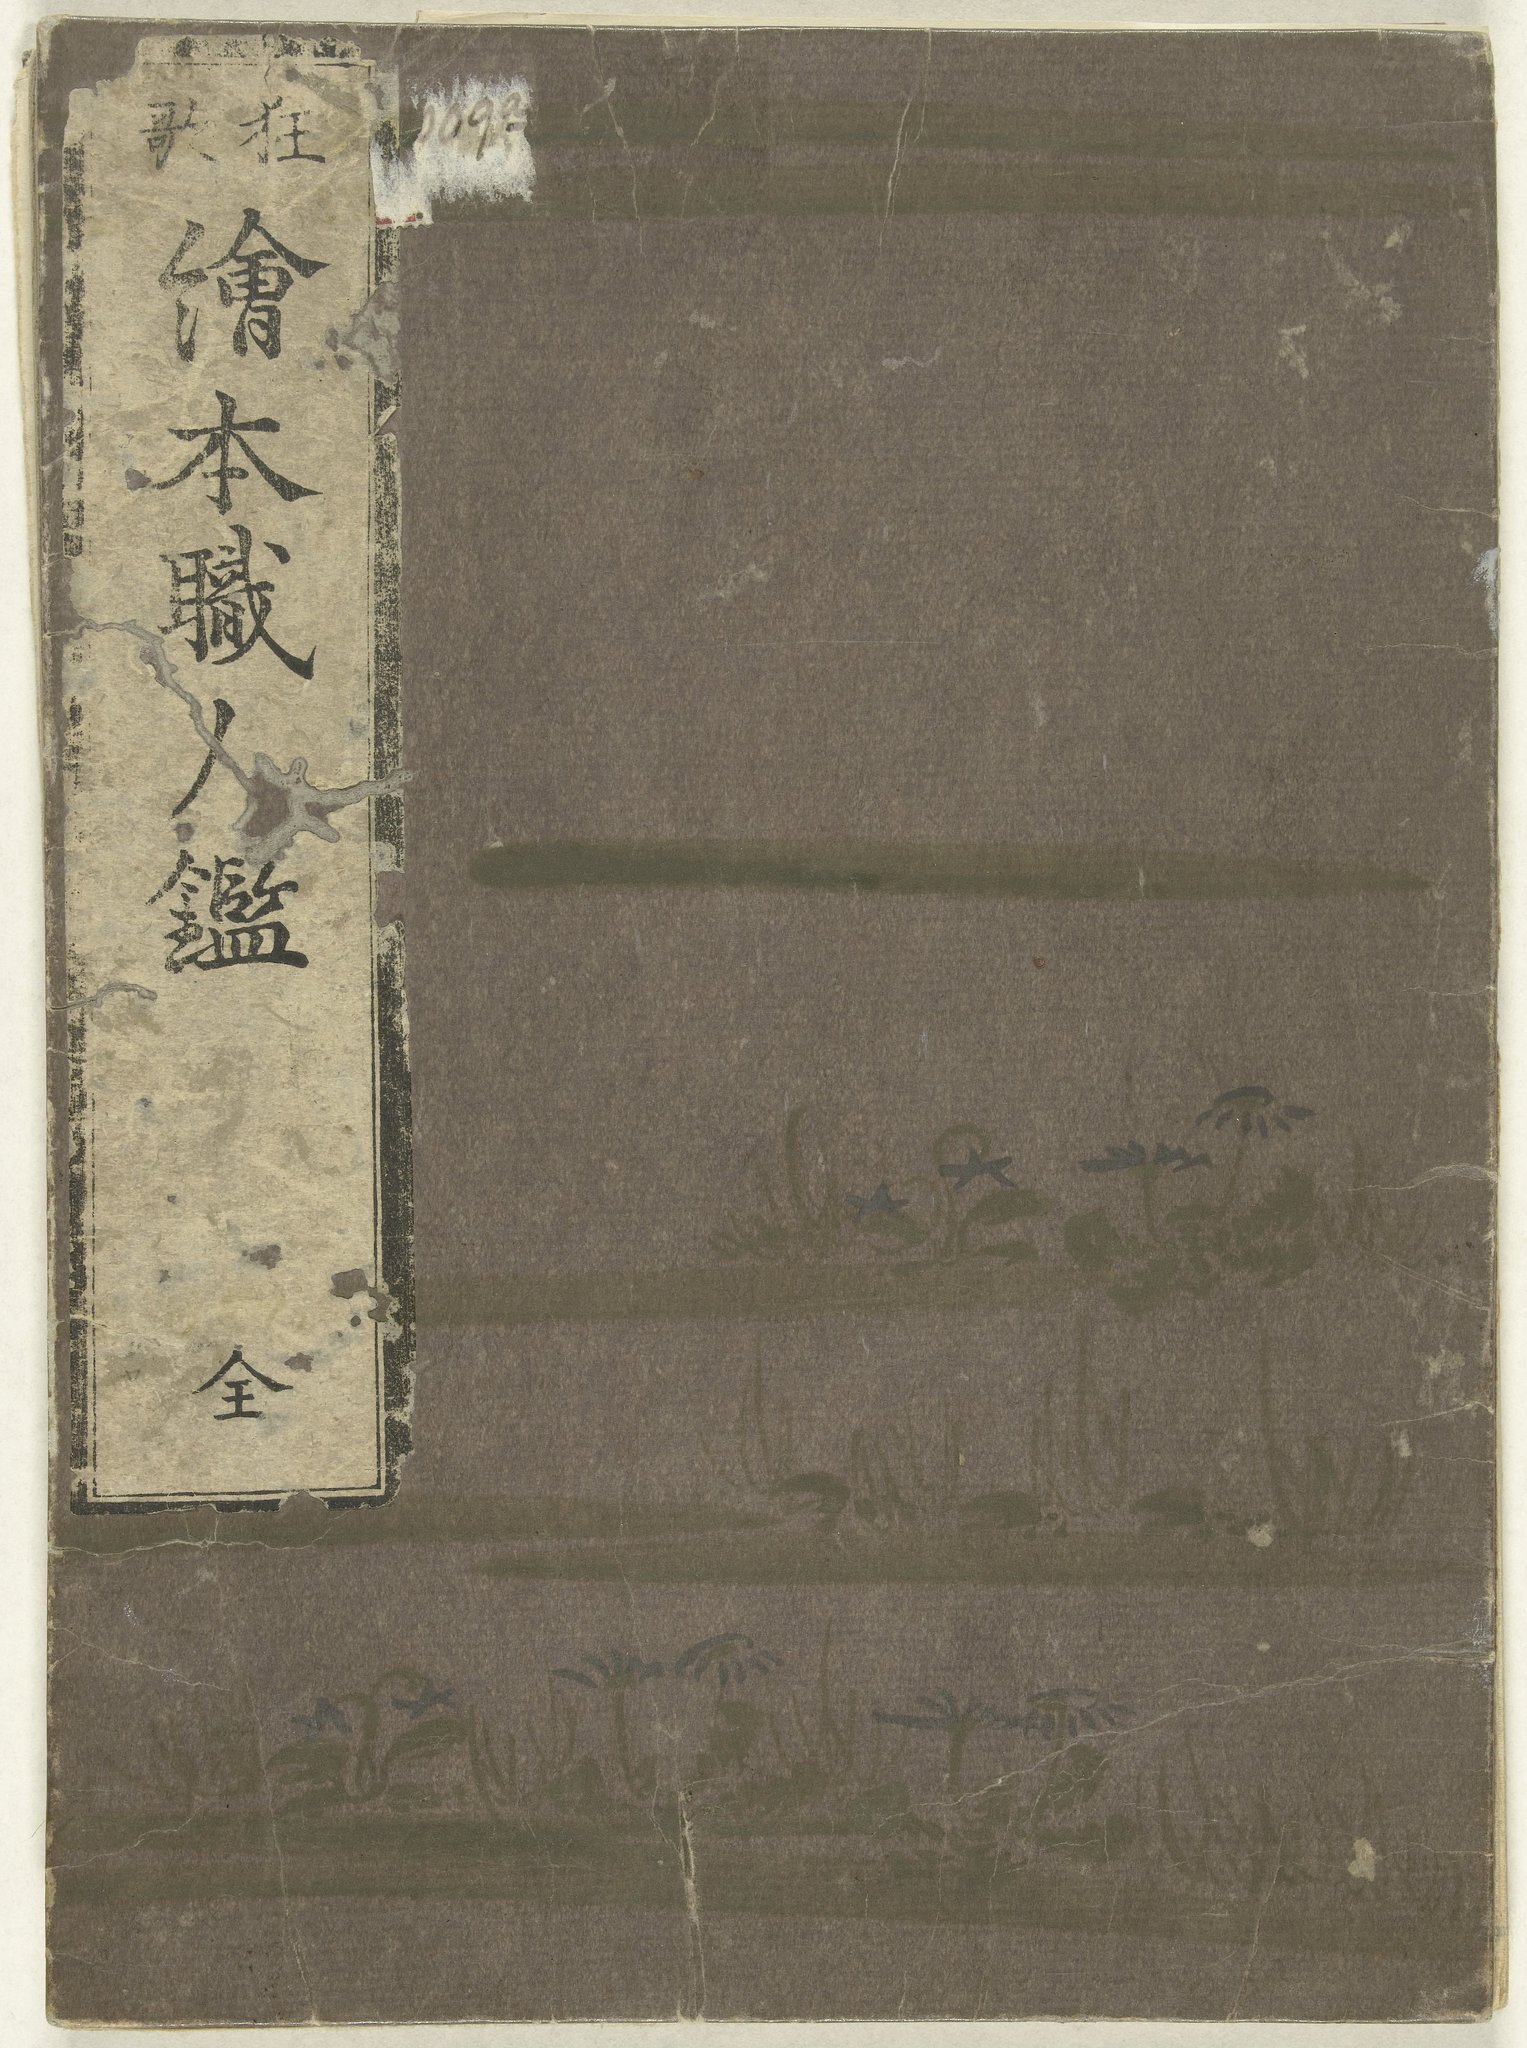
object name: book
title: Spiegel van meesterlijke ambachtslieden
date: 1803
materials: paint, paper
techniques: woodcut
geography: japan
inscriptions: date